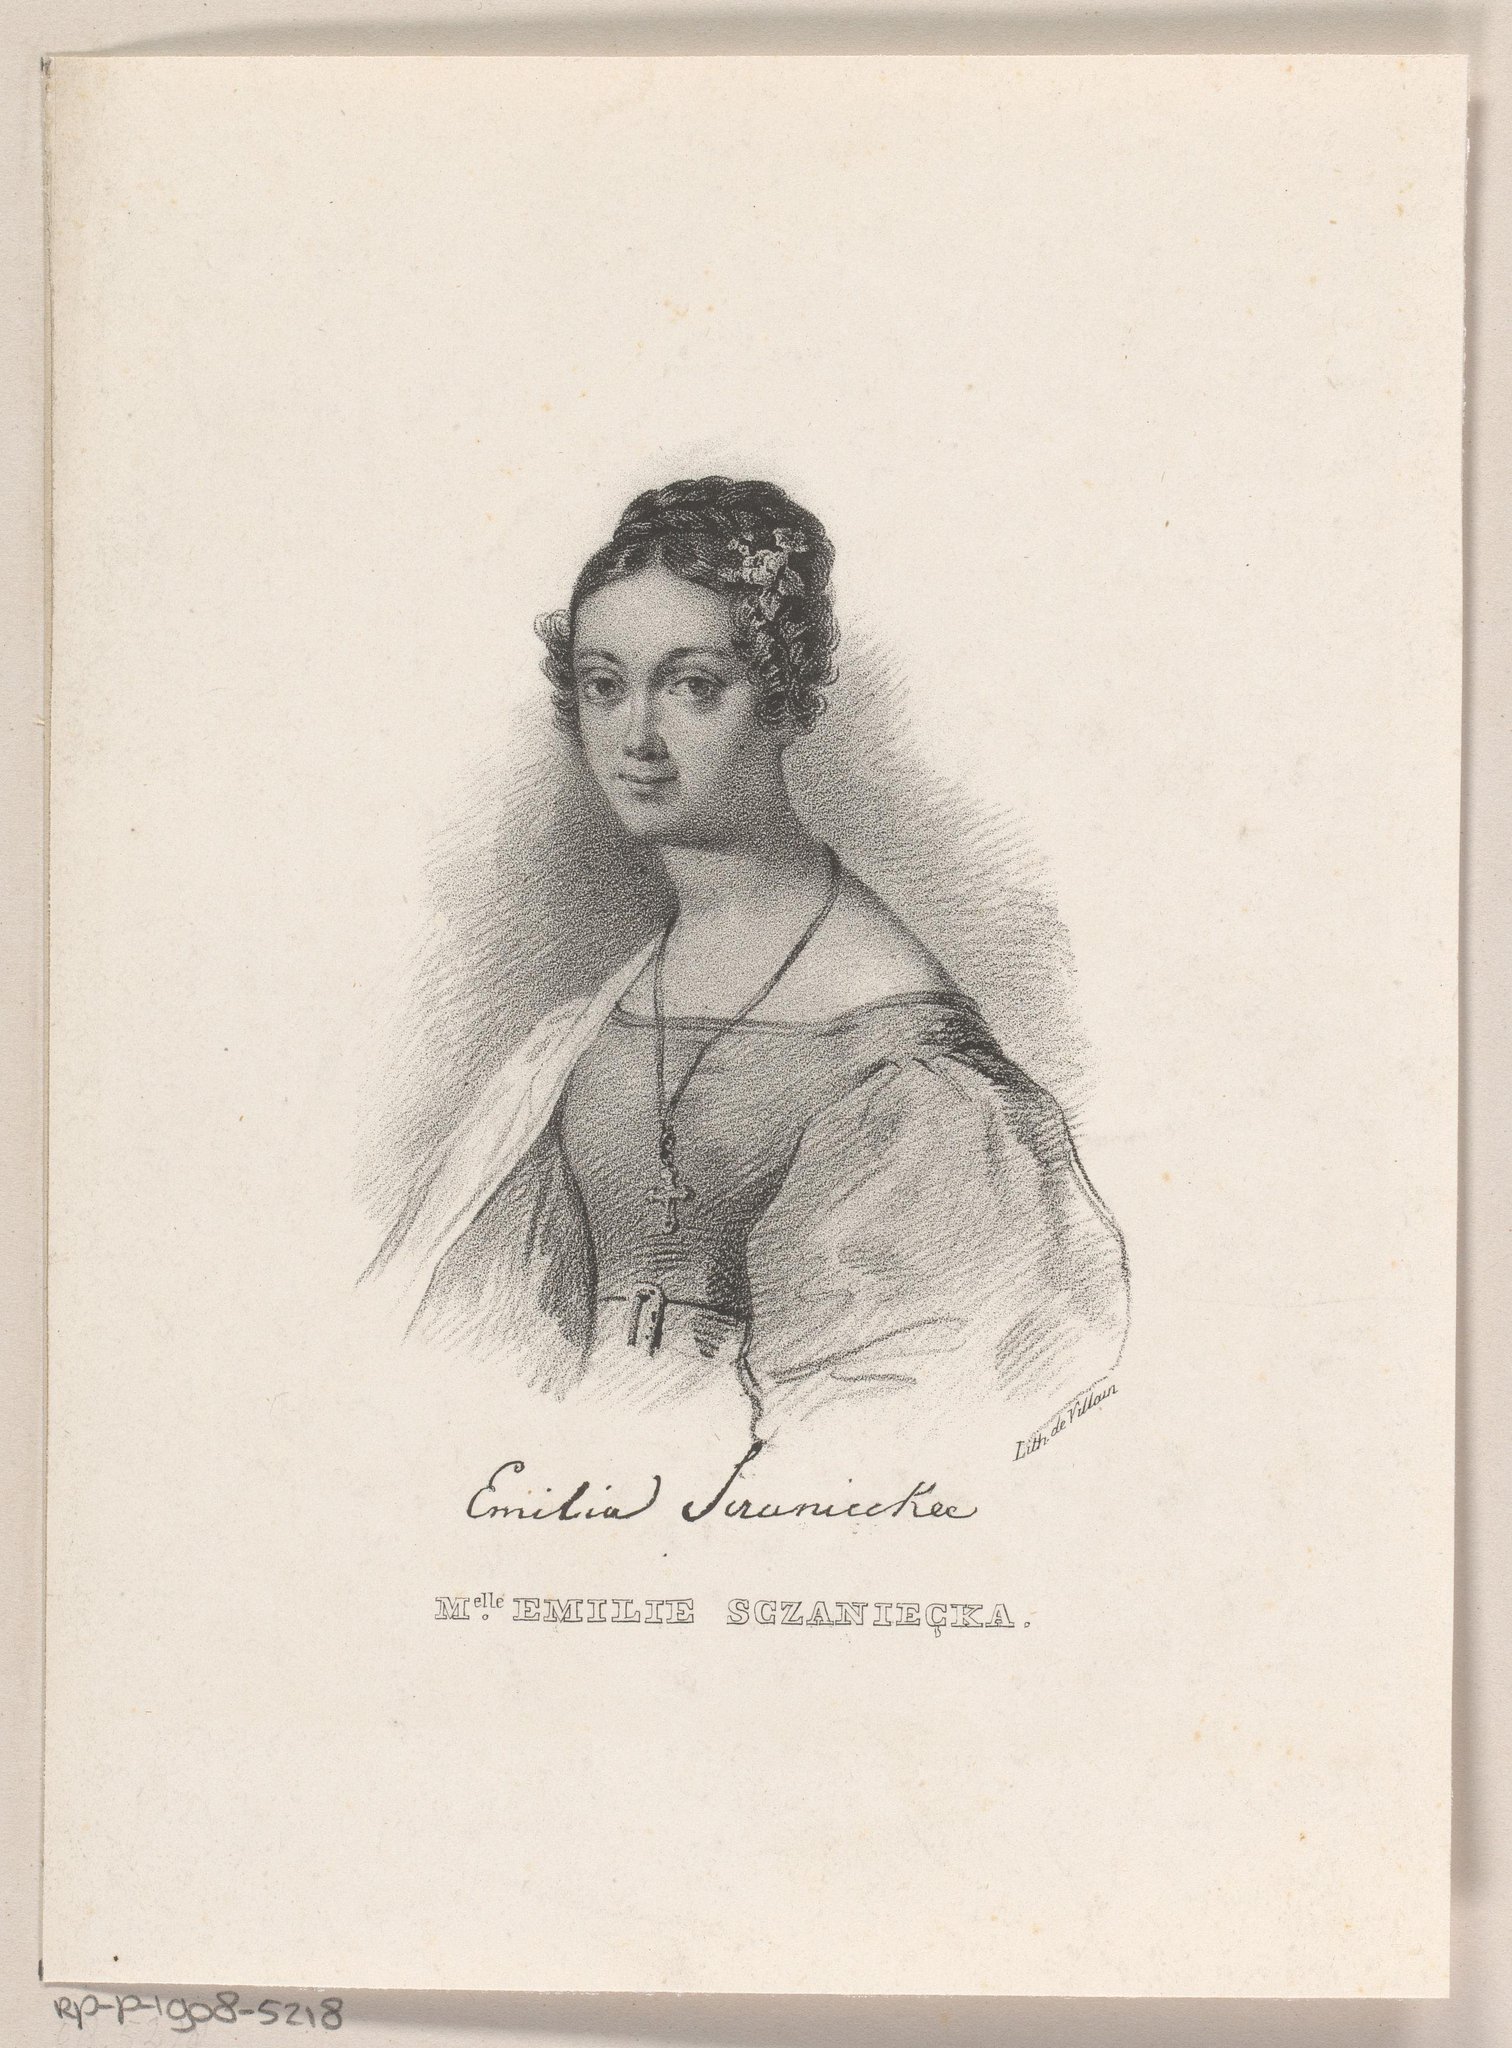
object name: print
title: Portret van Emilia Sczaniecka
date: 1832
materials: paper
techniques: lithograph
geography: paris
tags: historical persons - bb - woman, patriot (revolutionary)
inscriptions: collector's mark: Lugt 2228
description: Prent waarschijnlijk uit: Straszewicz, Joseph. Les polonais et les polonaises de la révolution du 29 novembre 1830 (...). Parijs: Catherine-Anaïs Pinard, 1832.